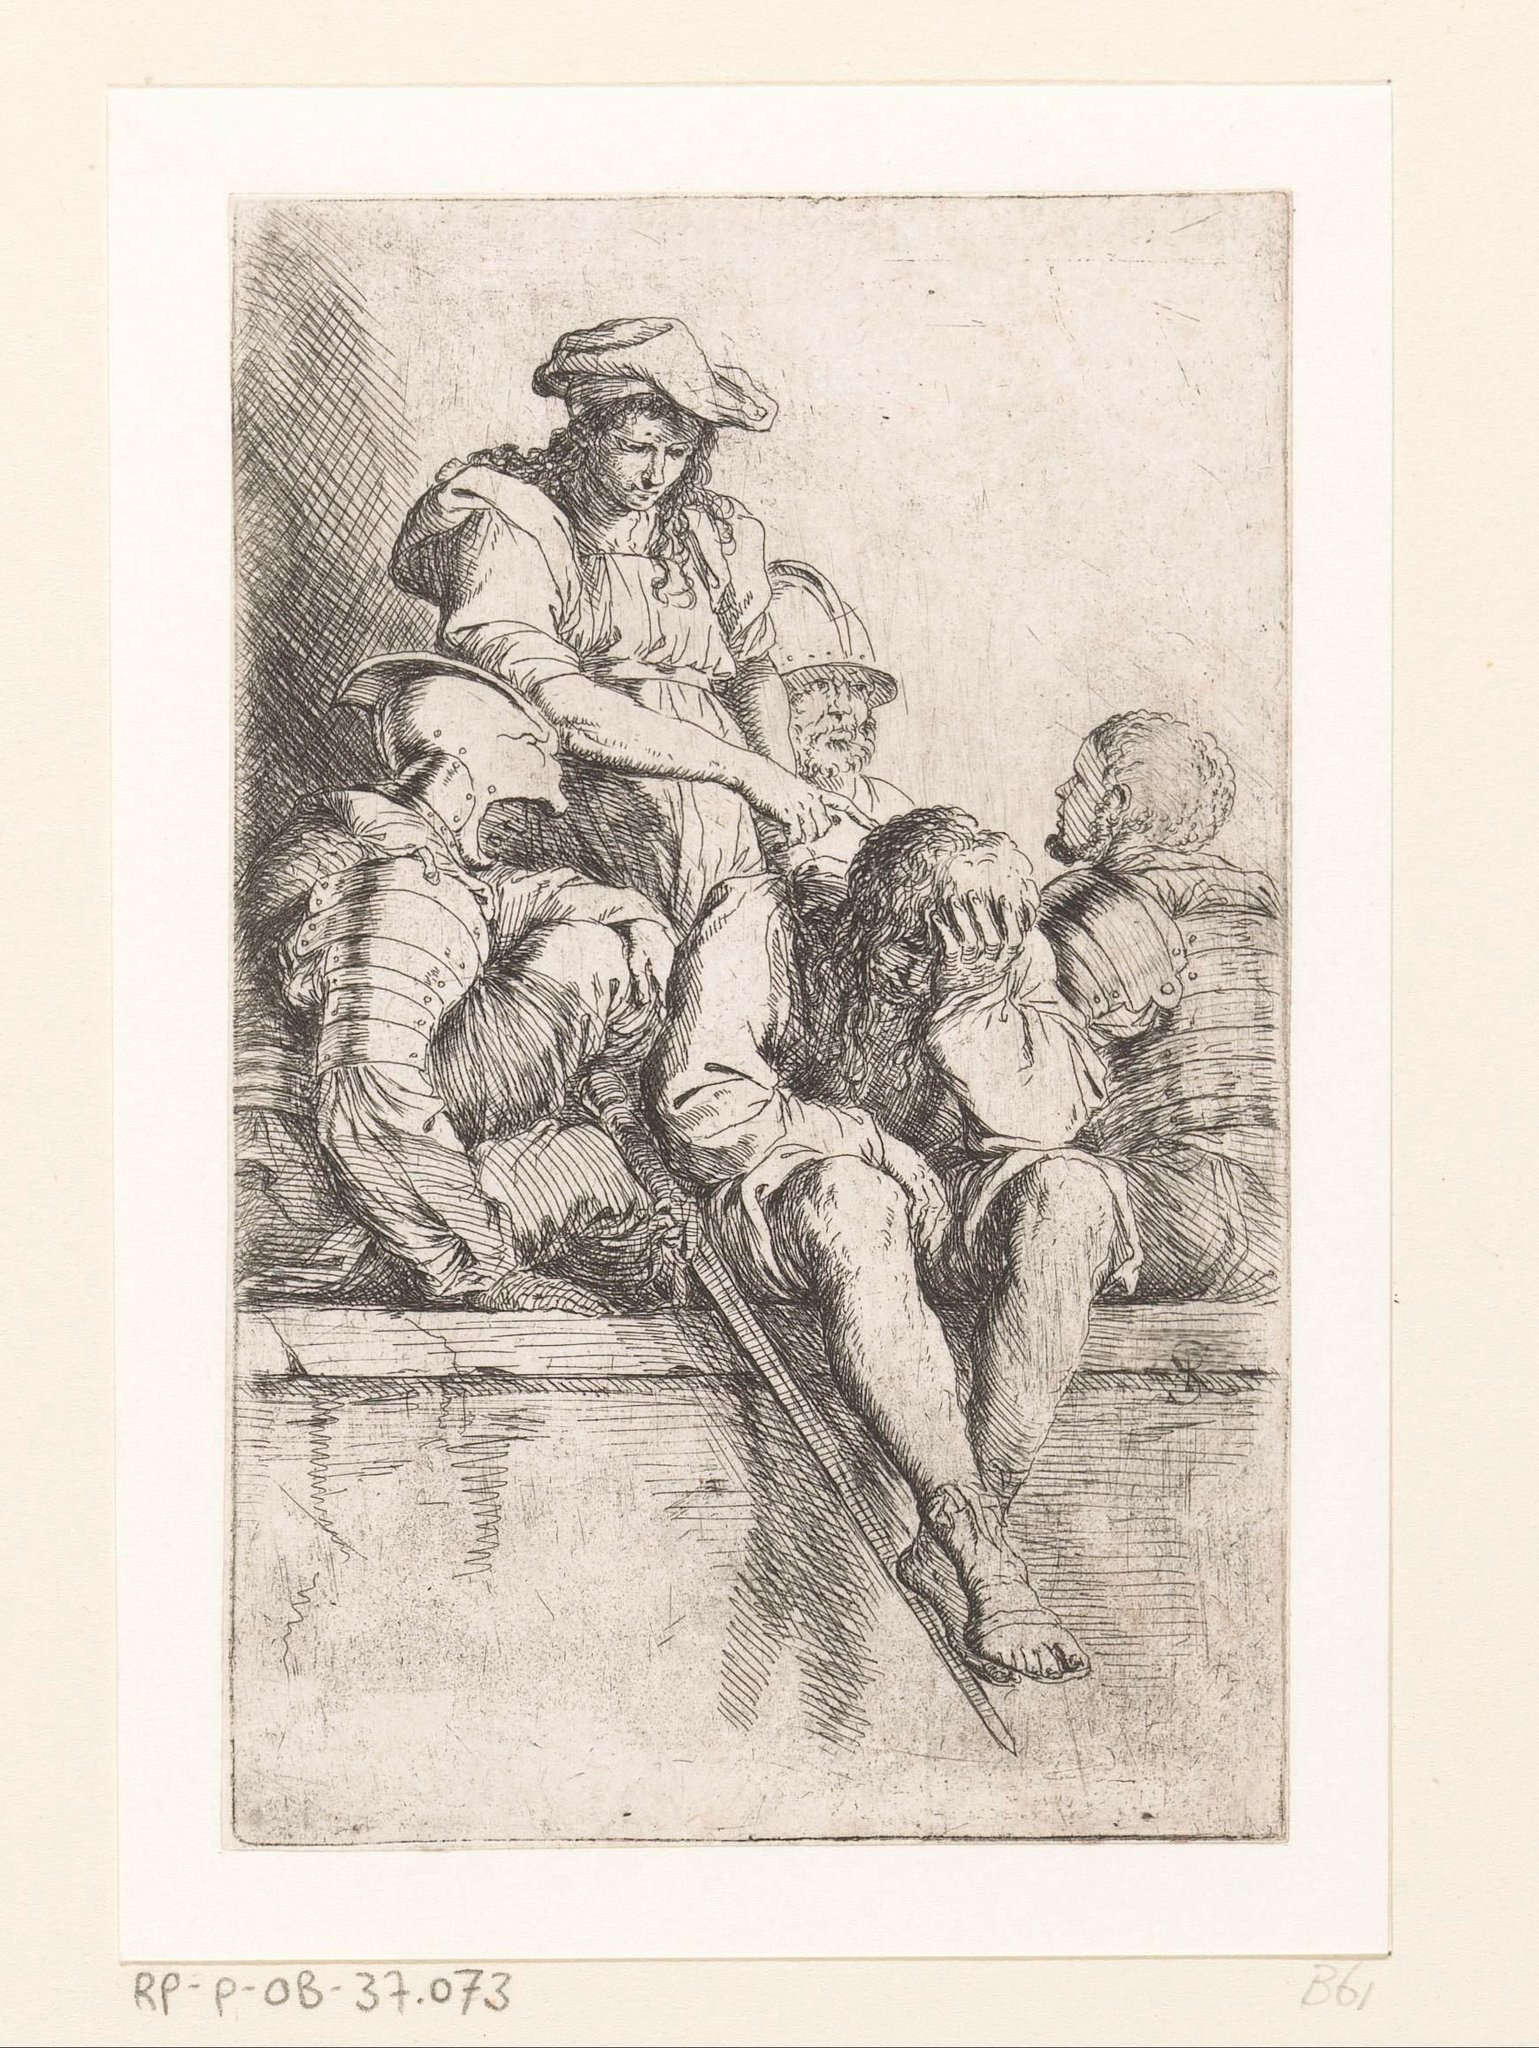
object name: print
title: Kleine figuren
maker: salvator rosa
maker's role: draughtsman, painter, print maker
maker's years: 1615-1673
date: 1656-1657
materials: paper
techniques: drypoint, etching, intaglio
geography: italy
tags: hacking and thrusting weapons: sword, the soldier; the soldier's life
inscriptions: collector's mark: Lugt 240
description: Deze prent maakt deel uit van de serie 'Figurine', bestaande uit een titelprent en 80 prenten van klein formaat met voorstellingen van mannelijke en vrouwelijke figuren. Rosa produceerde de serie waarschijnlijk gedurende de jaren 1656 en 1657.